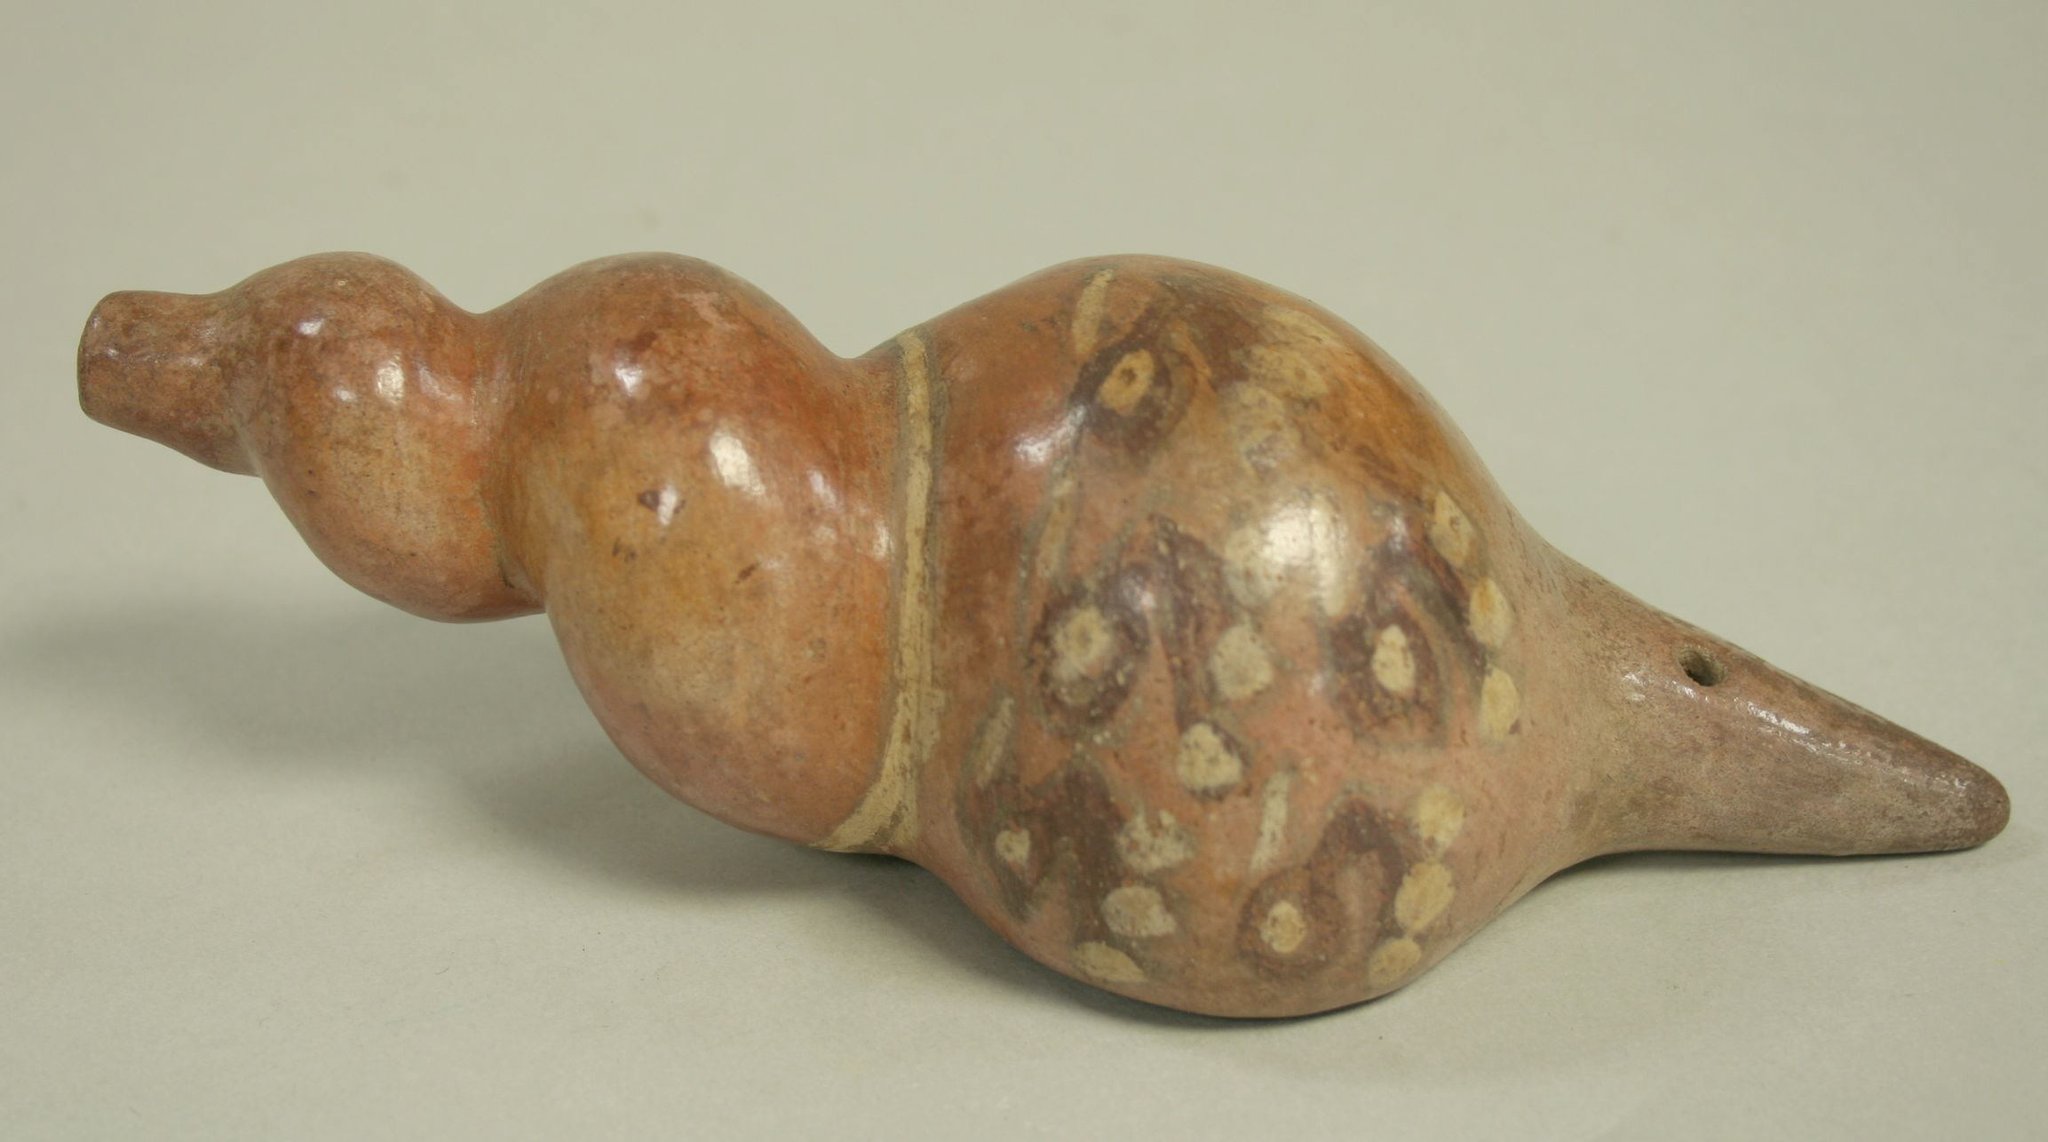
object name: trumpet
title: Ceramic Trumpet in the Form of a Shell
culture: central coast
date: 1001-1400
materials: ceramic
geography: peru